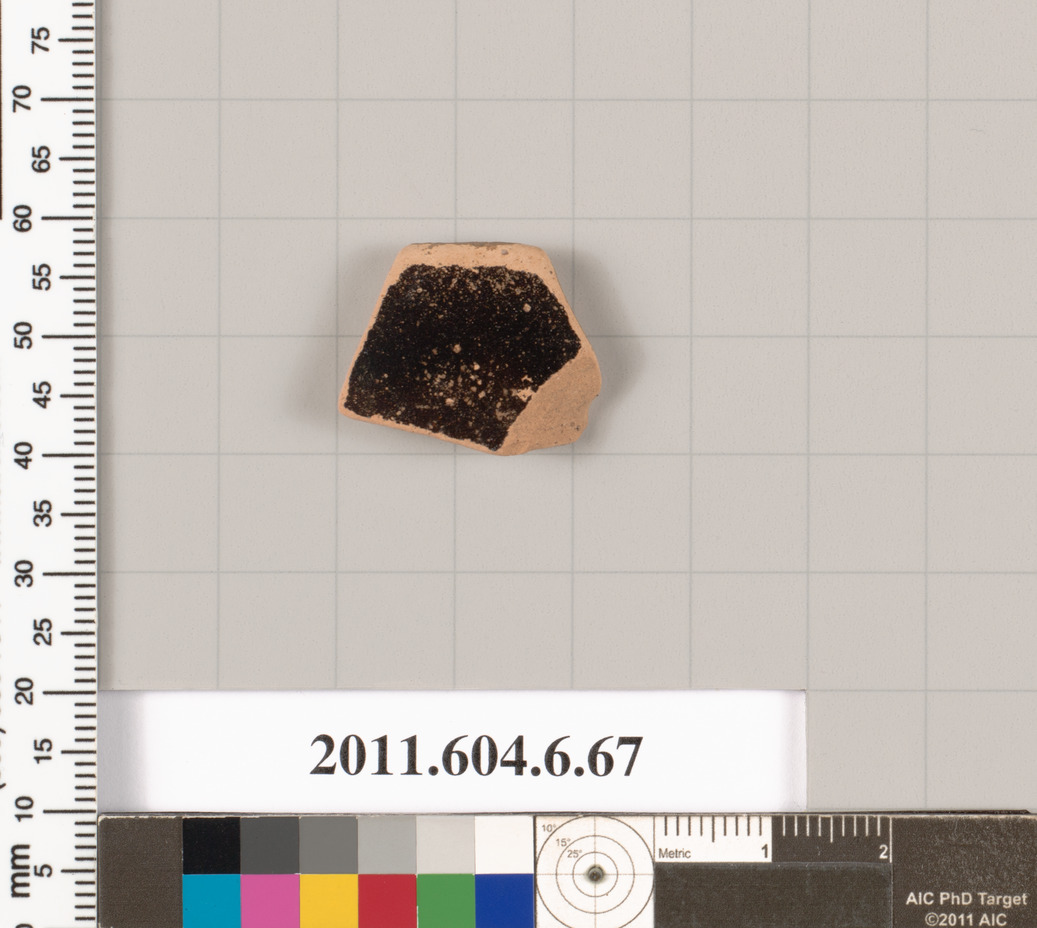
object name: undetermined open shape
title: Terracotta rim fragment of an open shape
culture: greek, attic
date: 600-401 BCE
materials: terracotta